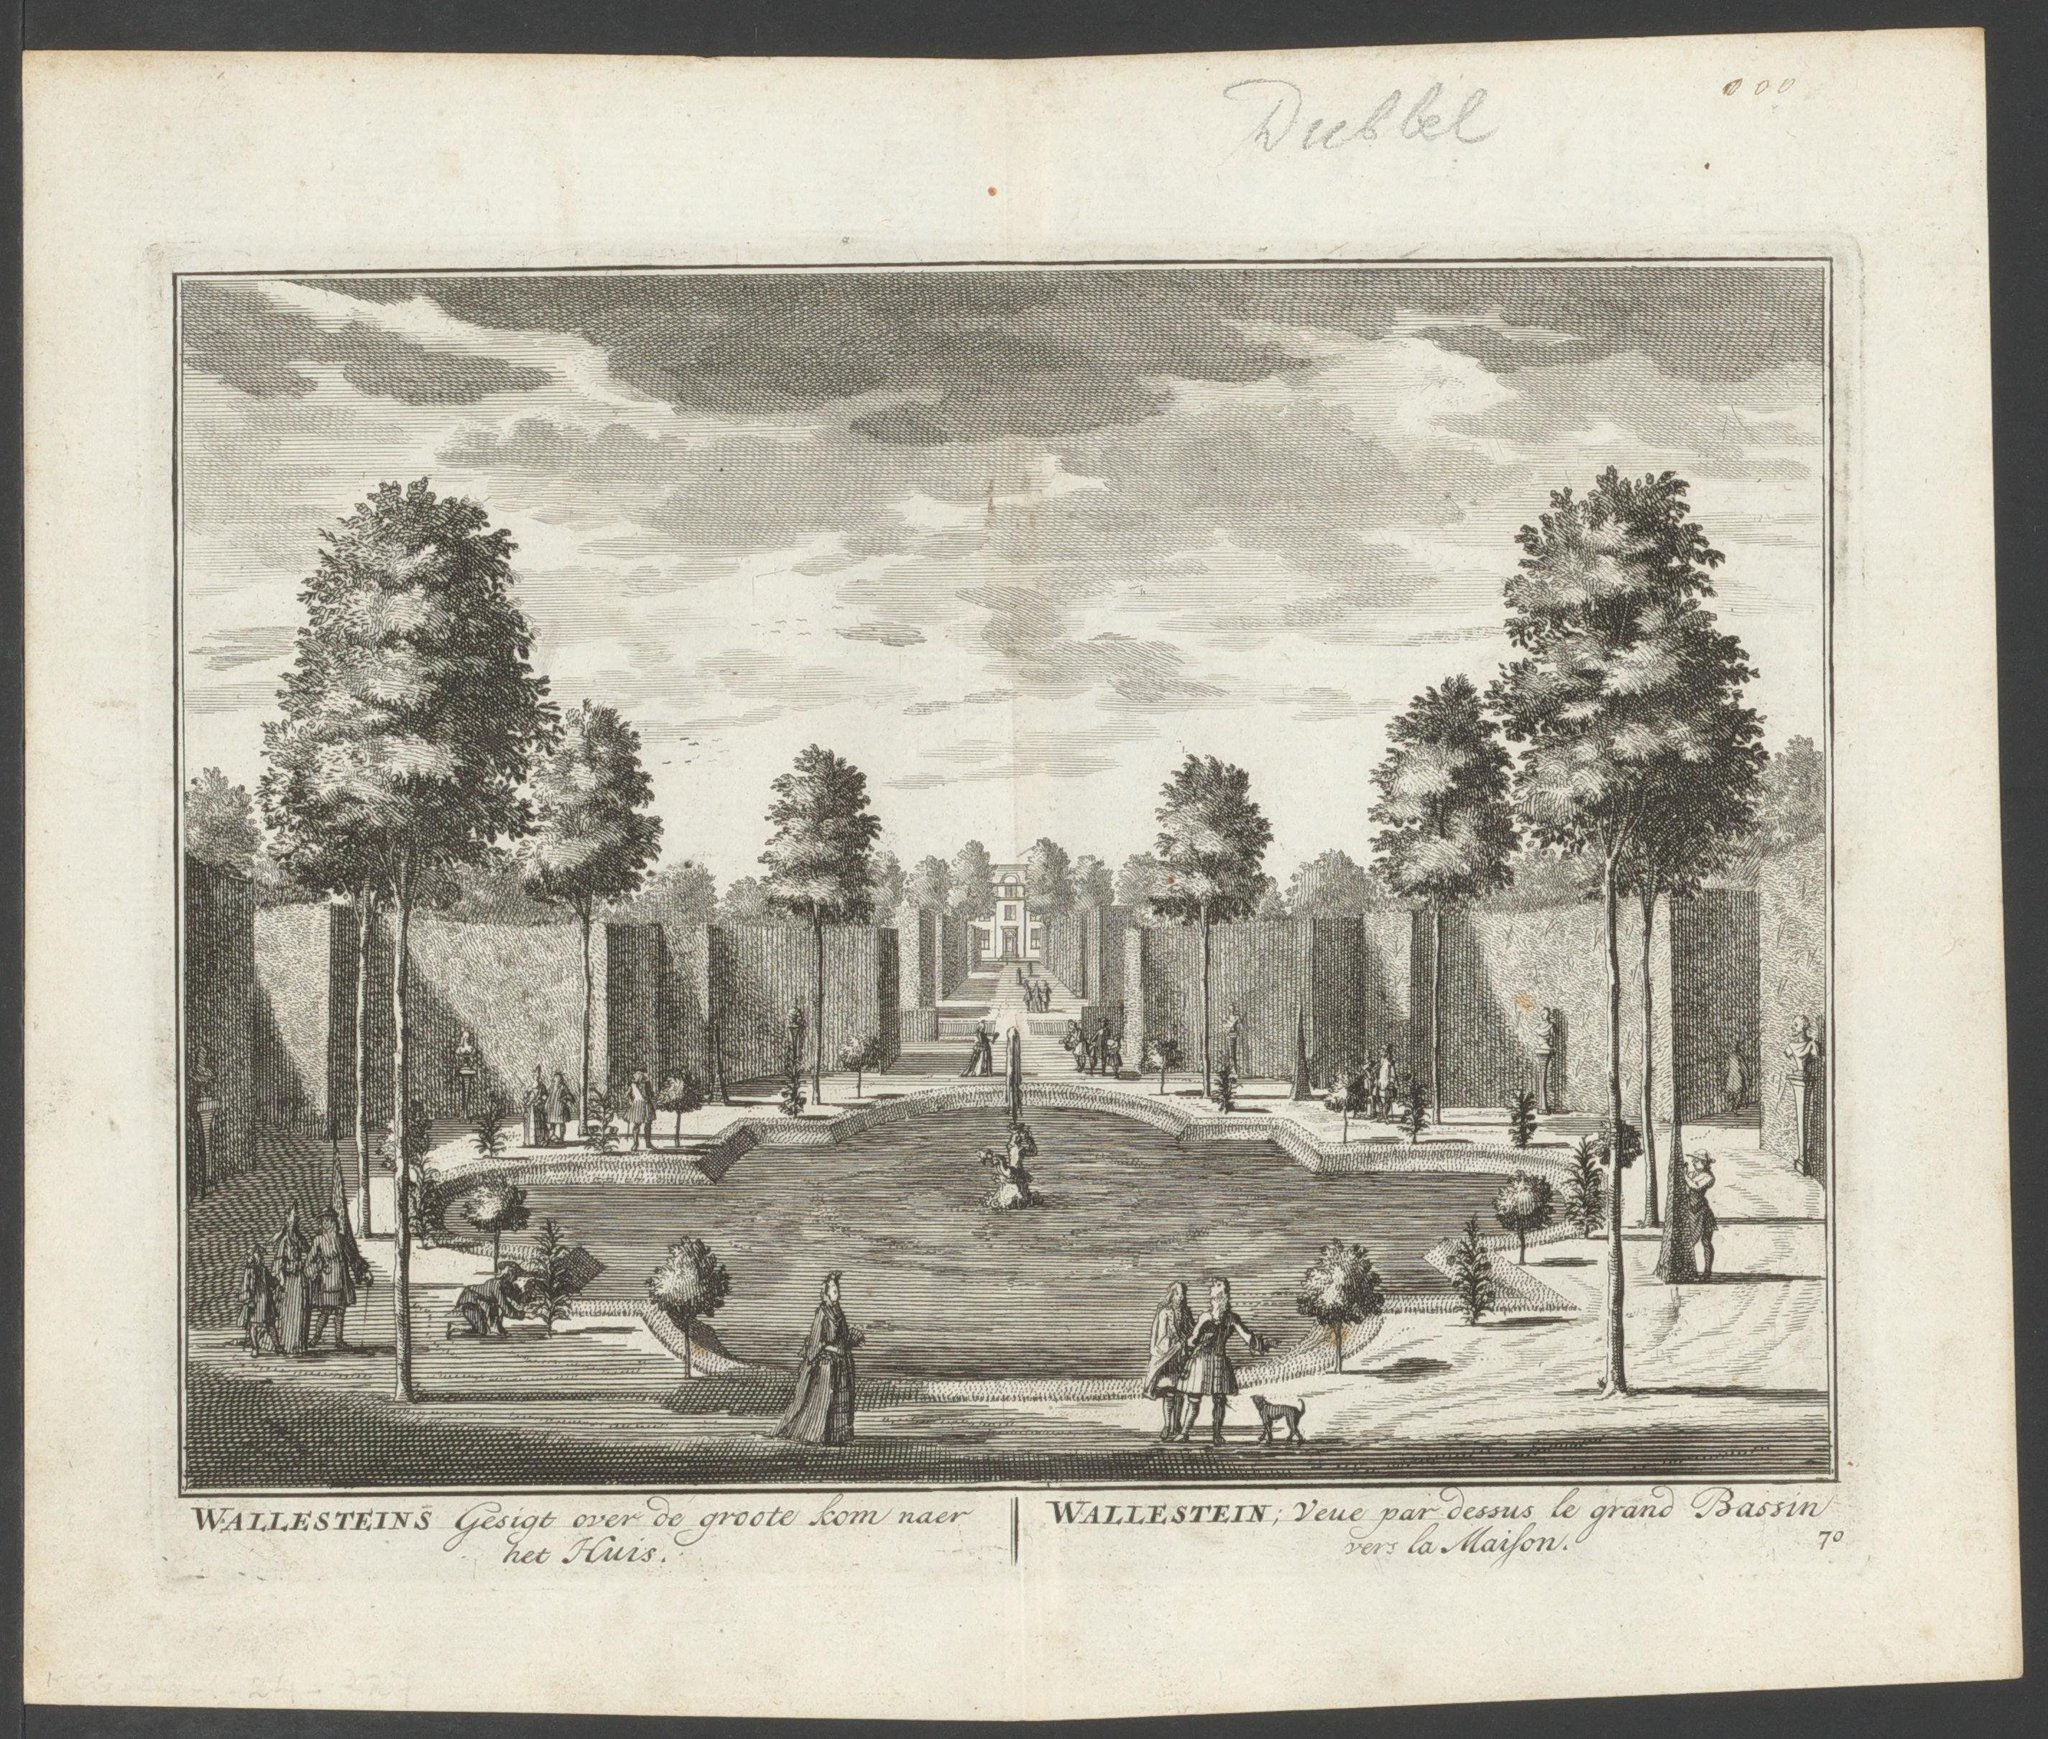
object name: print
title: Wallesteins Gesigt over de groote kom naer het Huis / Wallestein; Veue par dessus le grand Bassin vers la Maison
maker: daniël stopendaal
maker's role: print maker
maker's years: 1672-1726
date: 1719-1790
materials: paper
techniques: engraving, etching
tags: french or architectonic garden; formal garden, country-house, vecht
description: Prent voor het eerst gebruikt in: Leth, Andries de. De zegepraalende Vecht, vertoonende verscheidene gesichten van lustplaatsen, heeren huysen en dorpen, beginnende van Uitrecht en met Muyden besluytende (...). Amsterdam: Weduwe Nicolaus Visscher, 1719. Prent mogelijk uit: Brouërius van Nidek, Matthaeus. De Vechtstroom, van Utrecht tot Muiden (...). Amsterdam: H. Gartman, W. Vermandel en J.W. Smit, 1790.